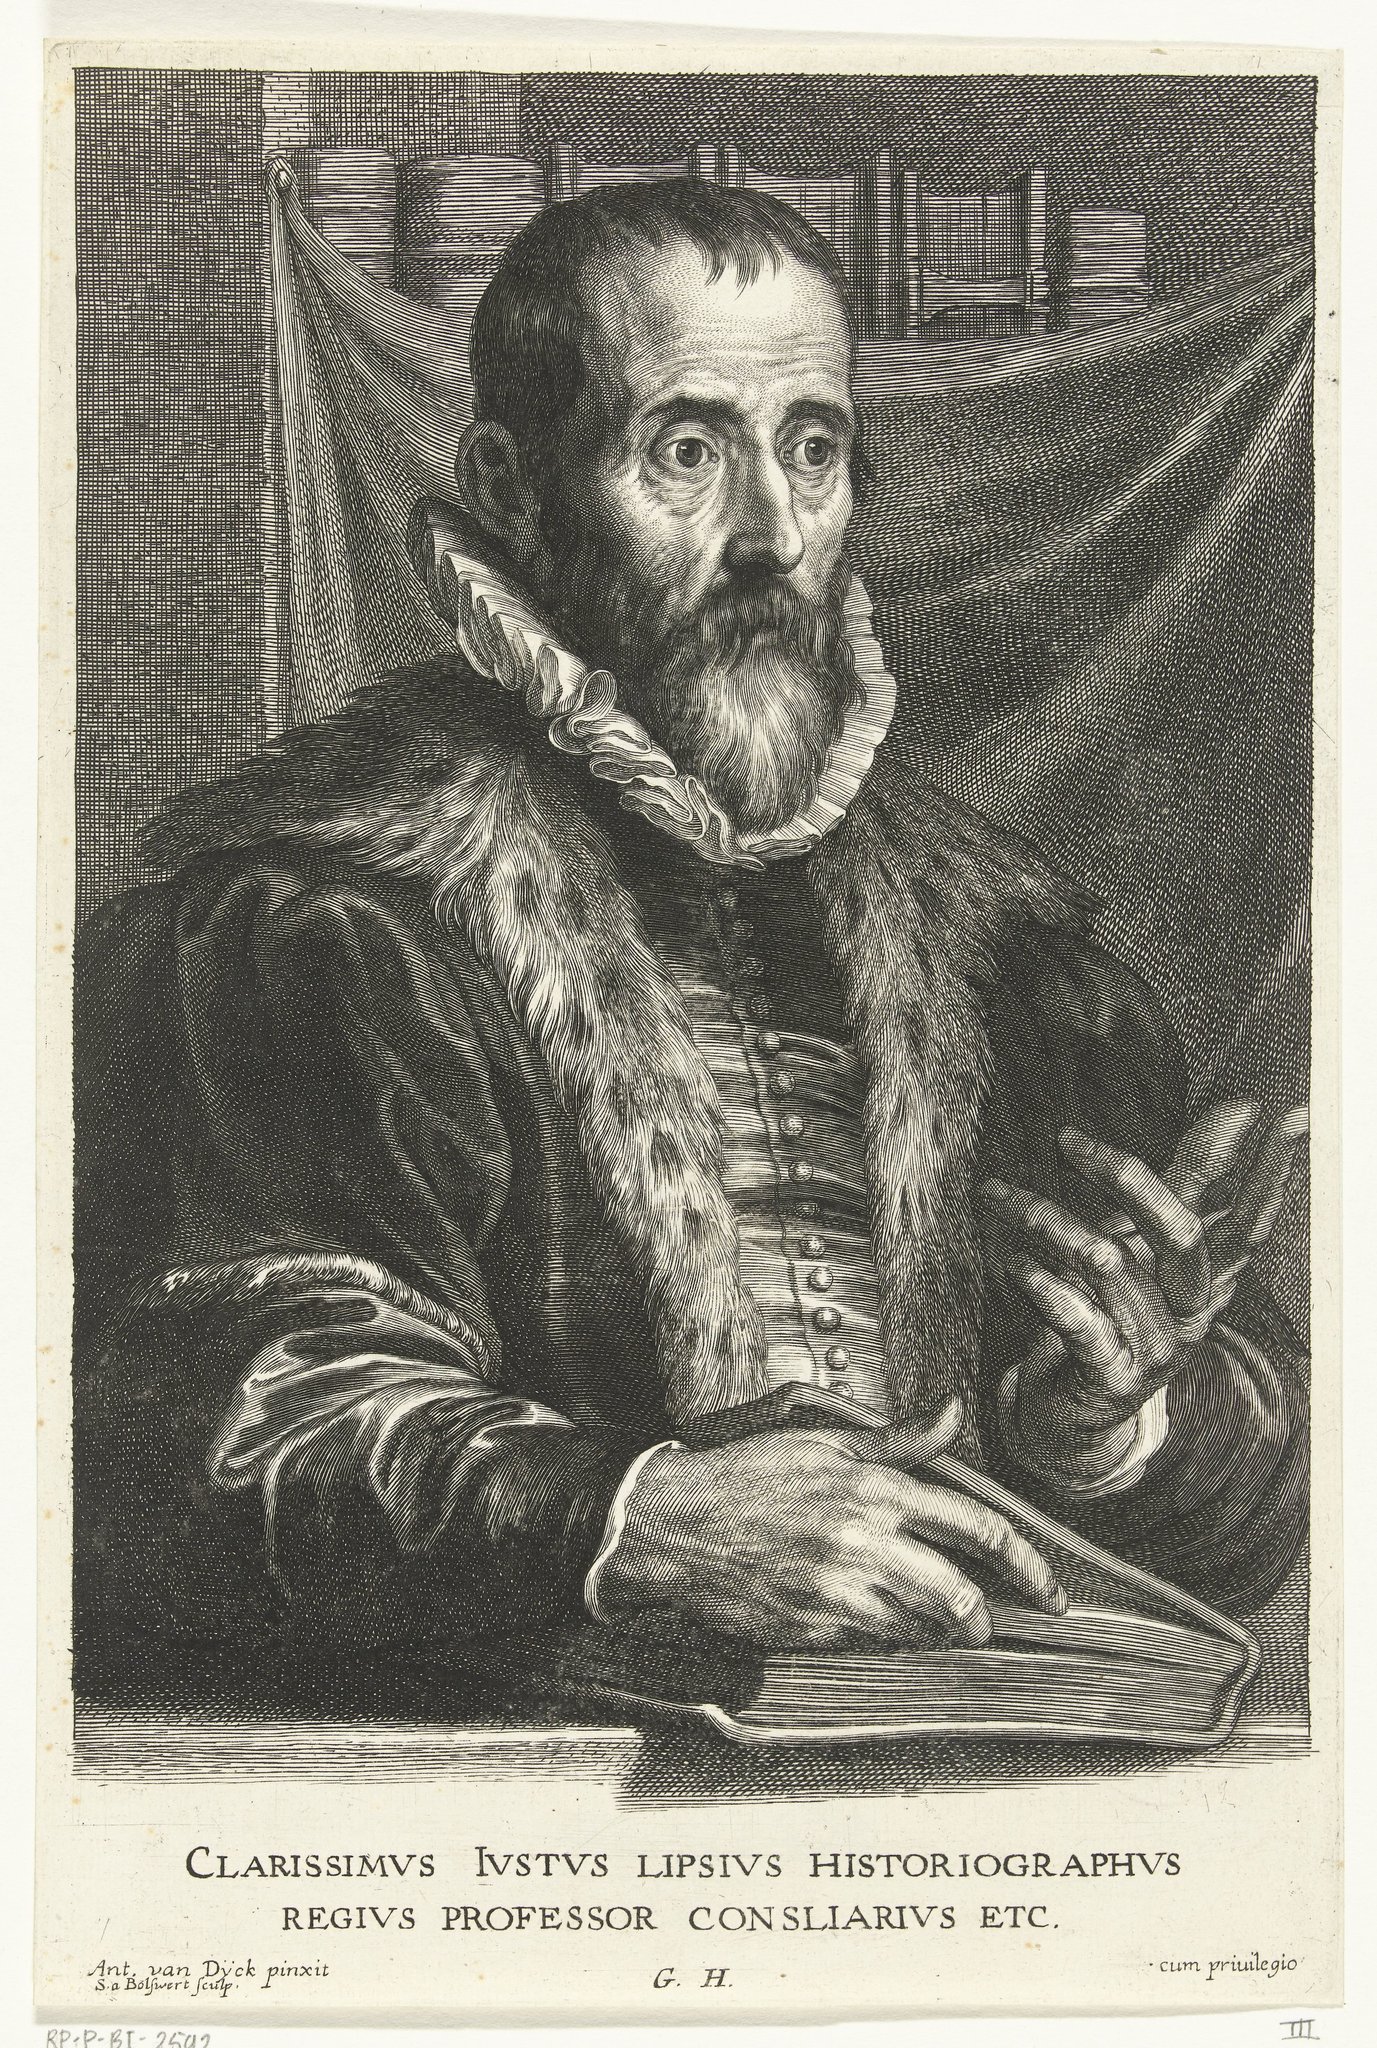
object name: print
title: Portret van historicus Justus Lipsius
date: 1596-1659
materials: paper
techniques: engraving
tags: louvain, justus lipsius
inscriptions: collector's mark: Lugt 240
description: Prent naar schilderij van Anthony van Dyck.